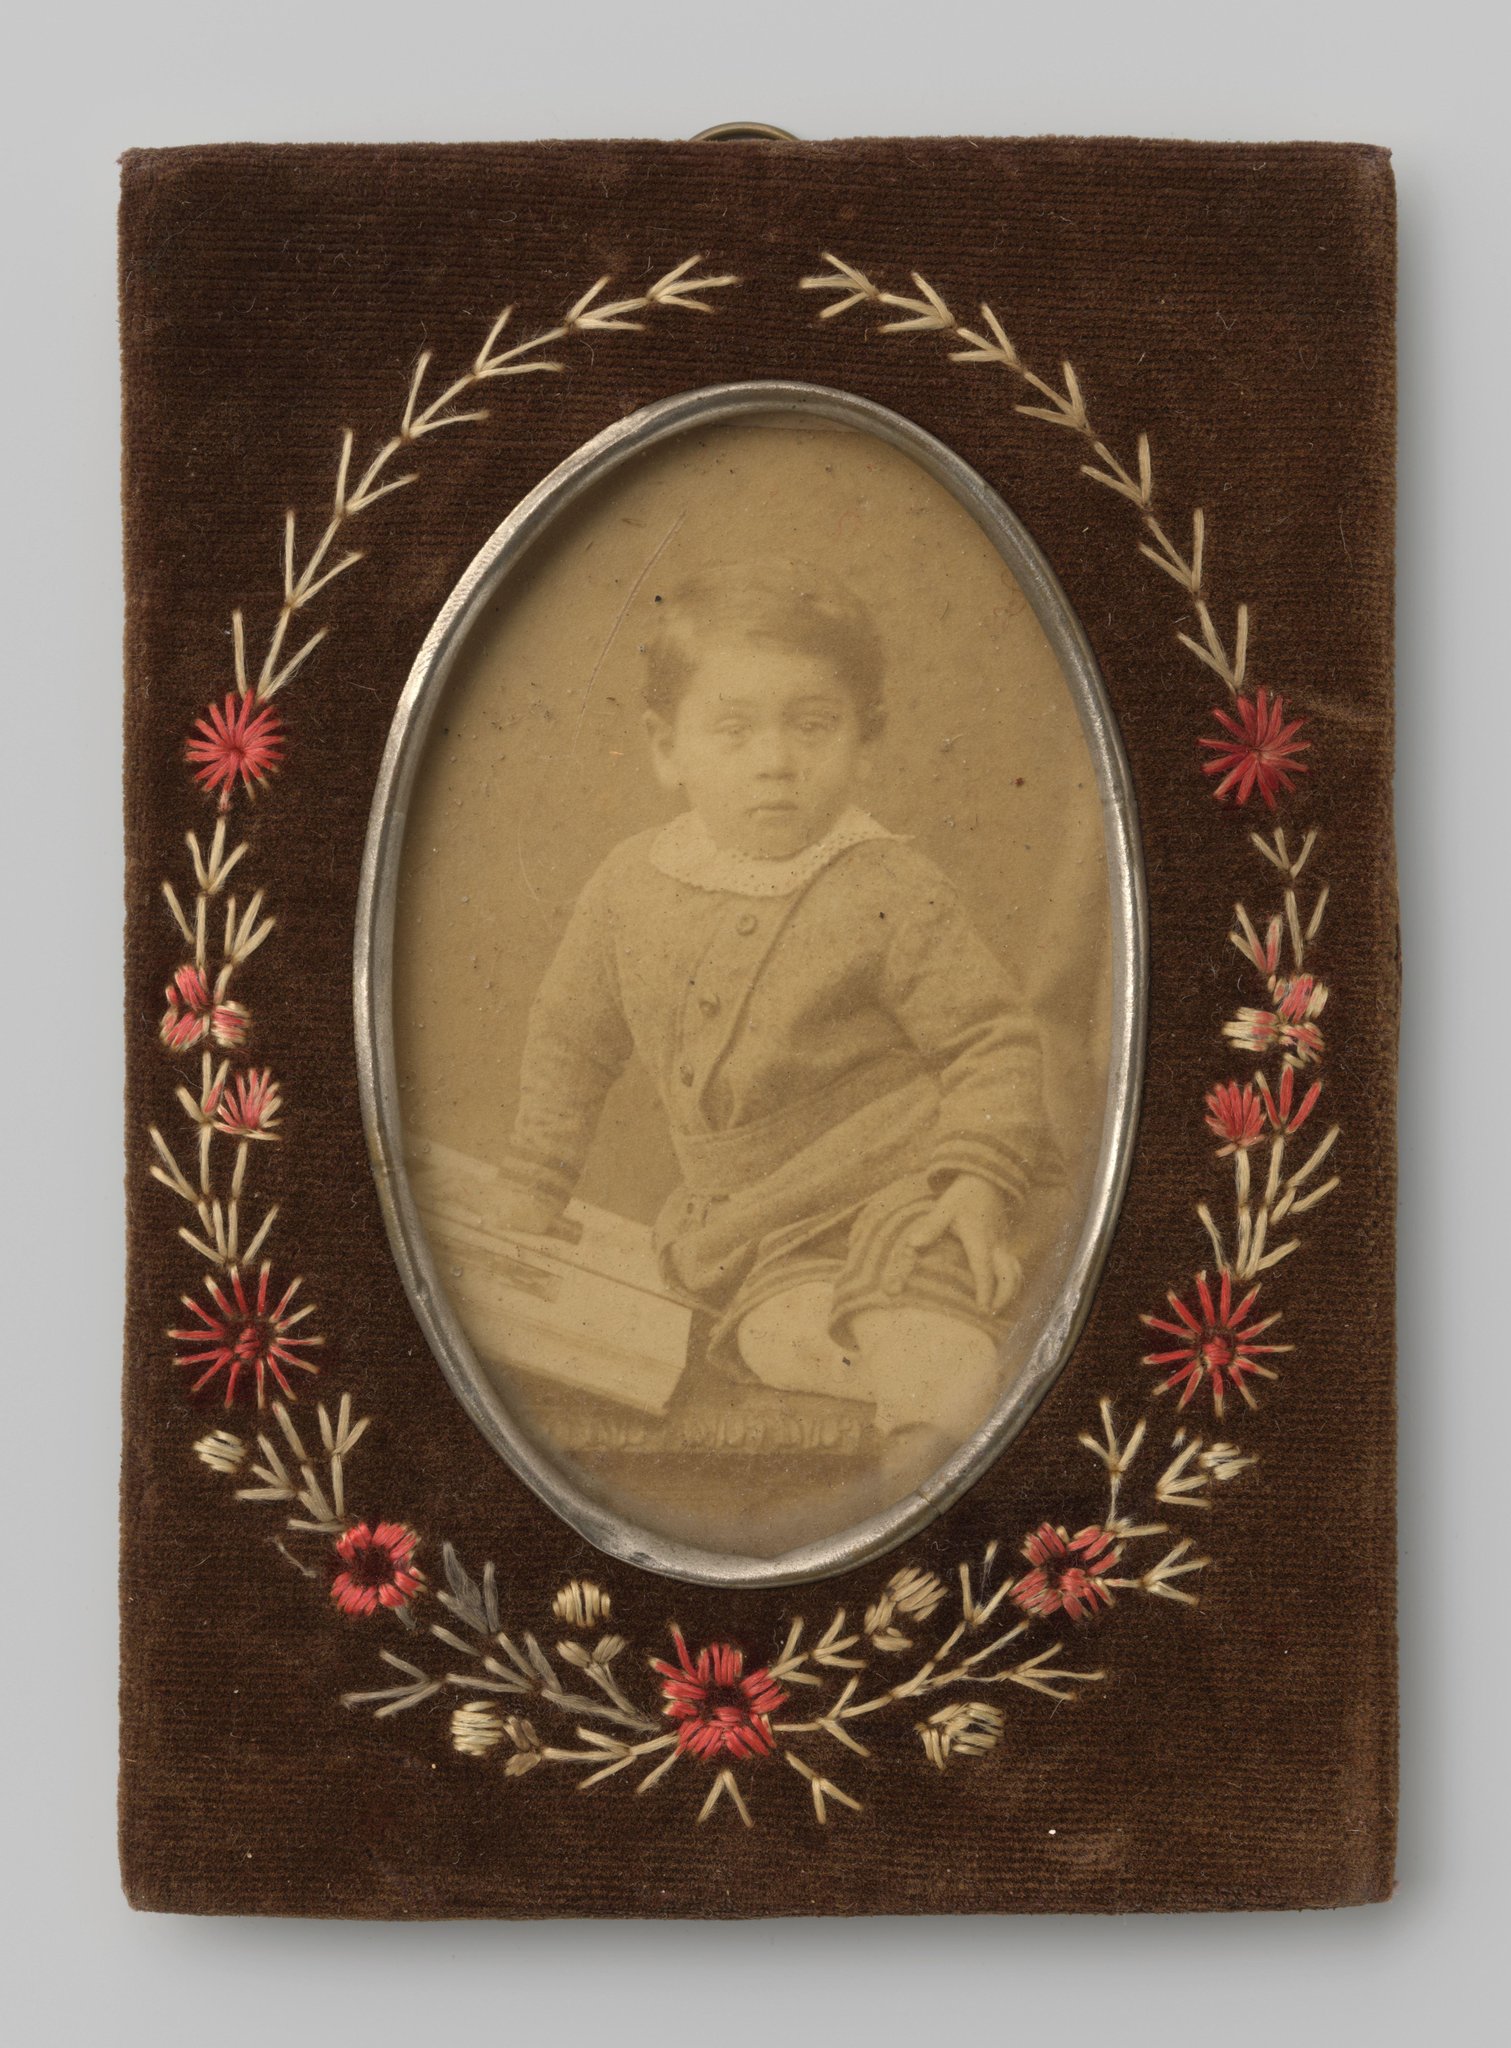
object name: frame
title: Portret van een onbekend kind met een boek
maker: Anonymous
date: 1880-1900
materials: cardboard, glass, metal, paper, textile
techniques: albumen print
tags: child, anonymous historical person portrayed